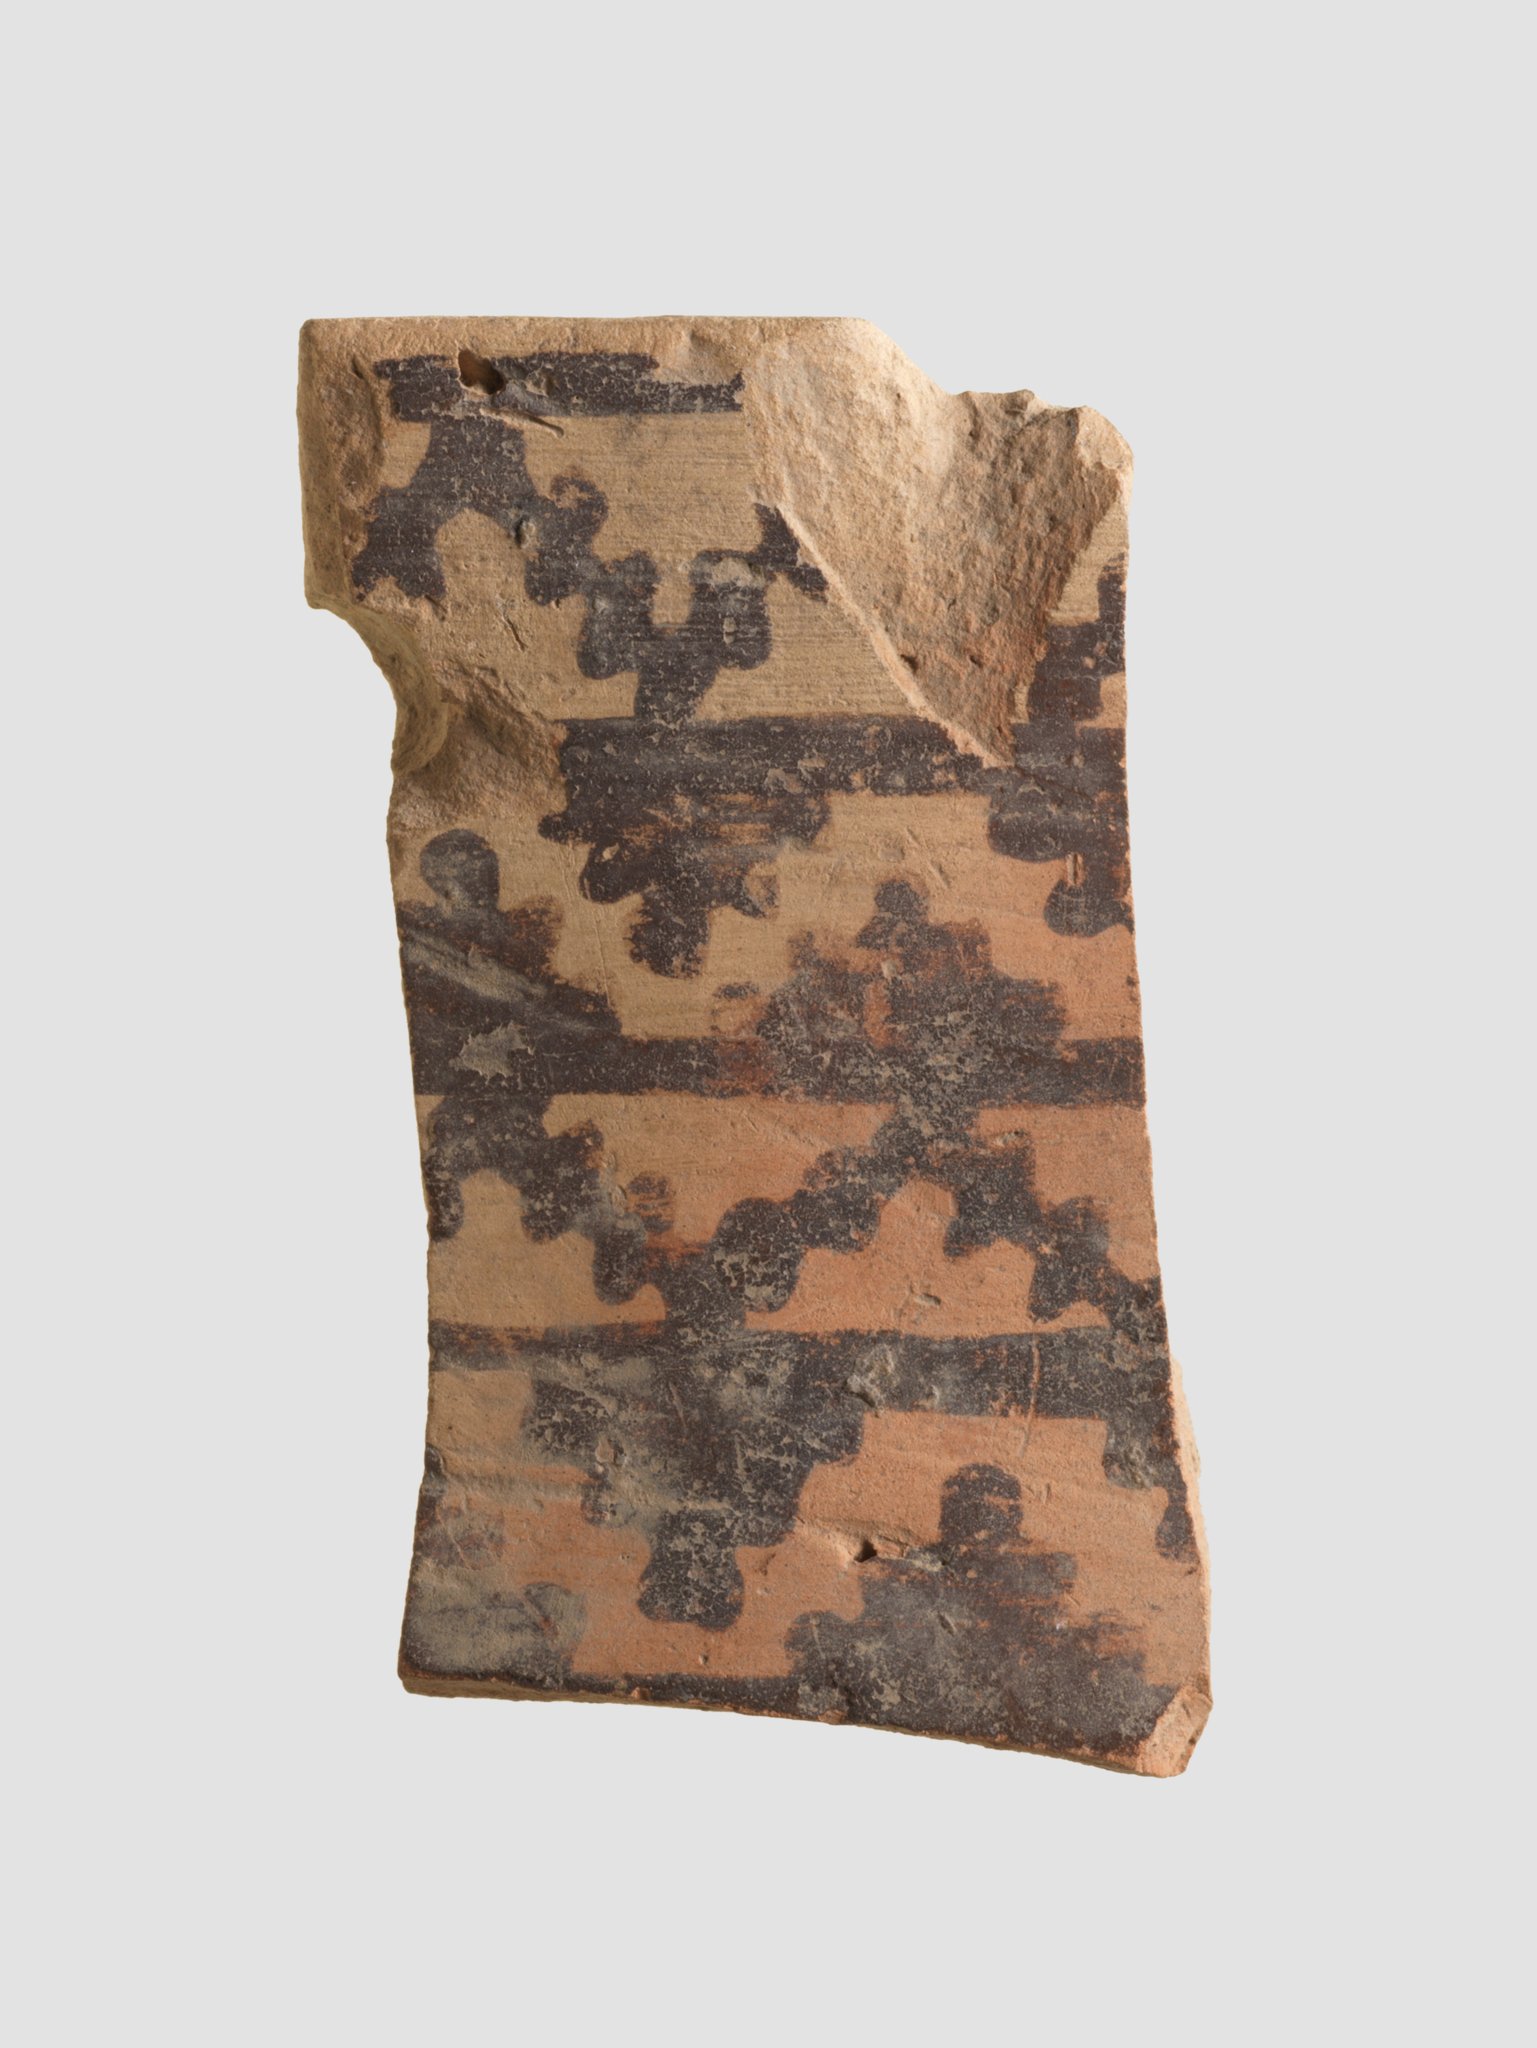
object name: sherd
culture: iranian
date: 2700-2500 BCE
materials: ceramic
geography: iran